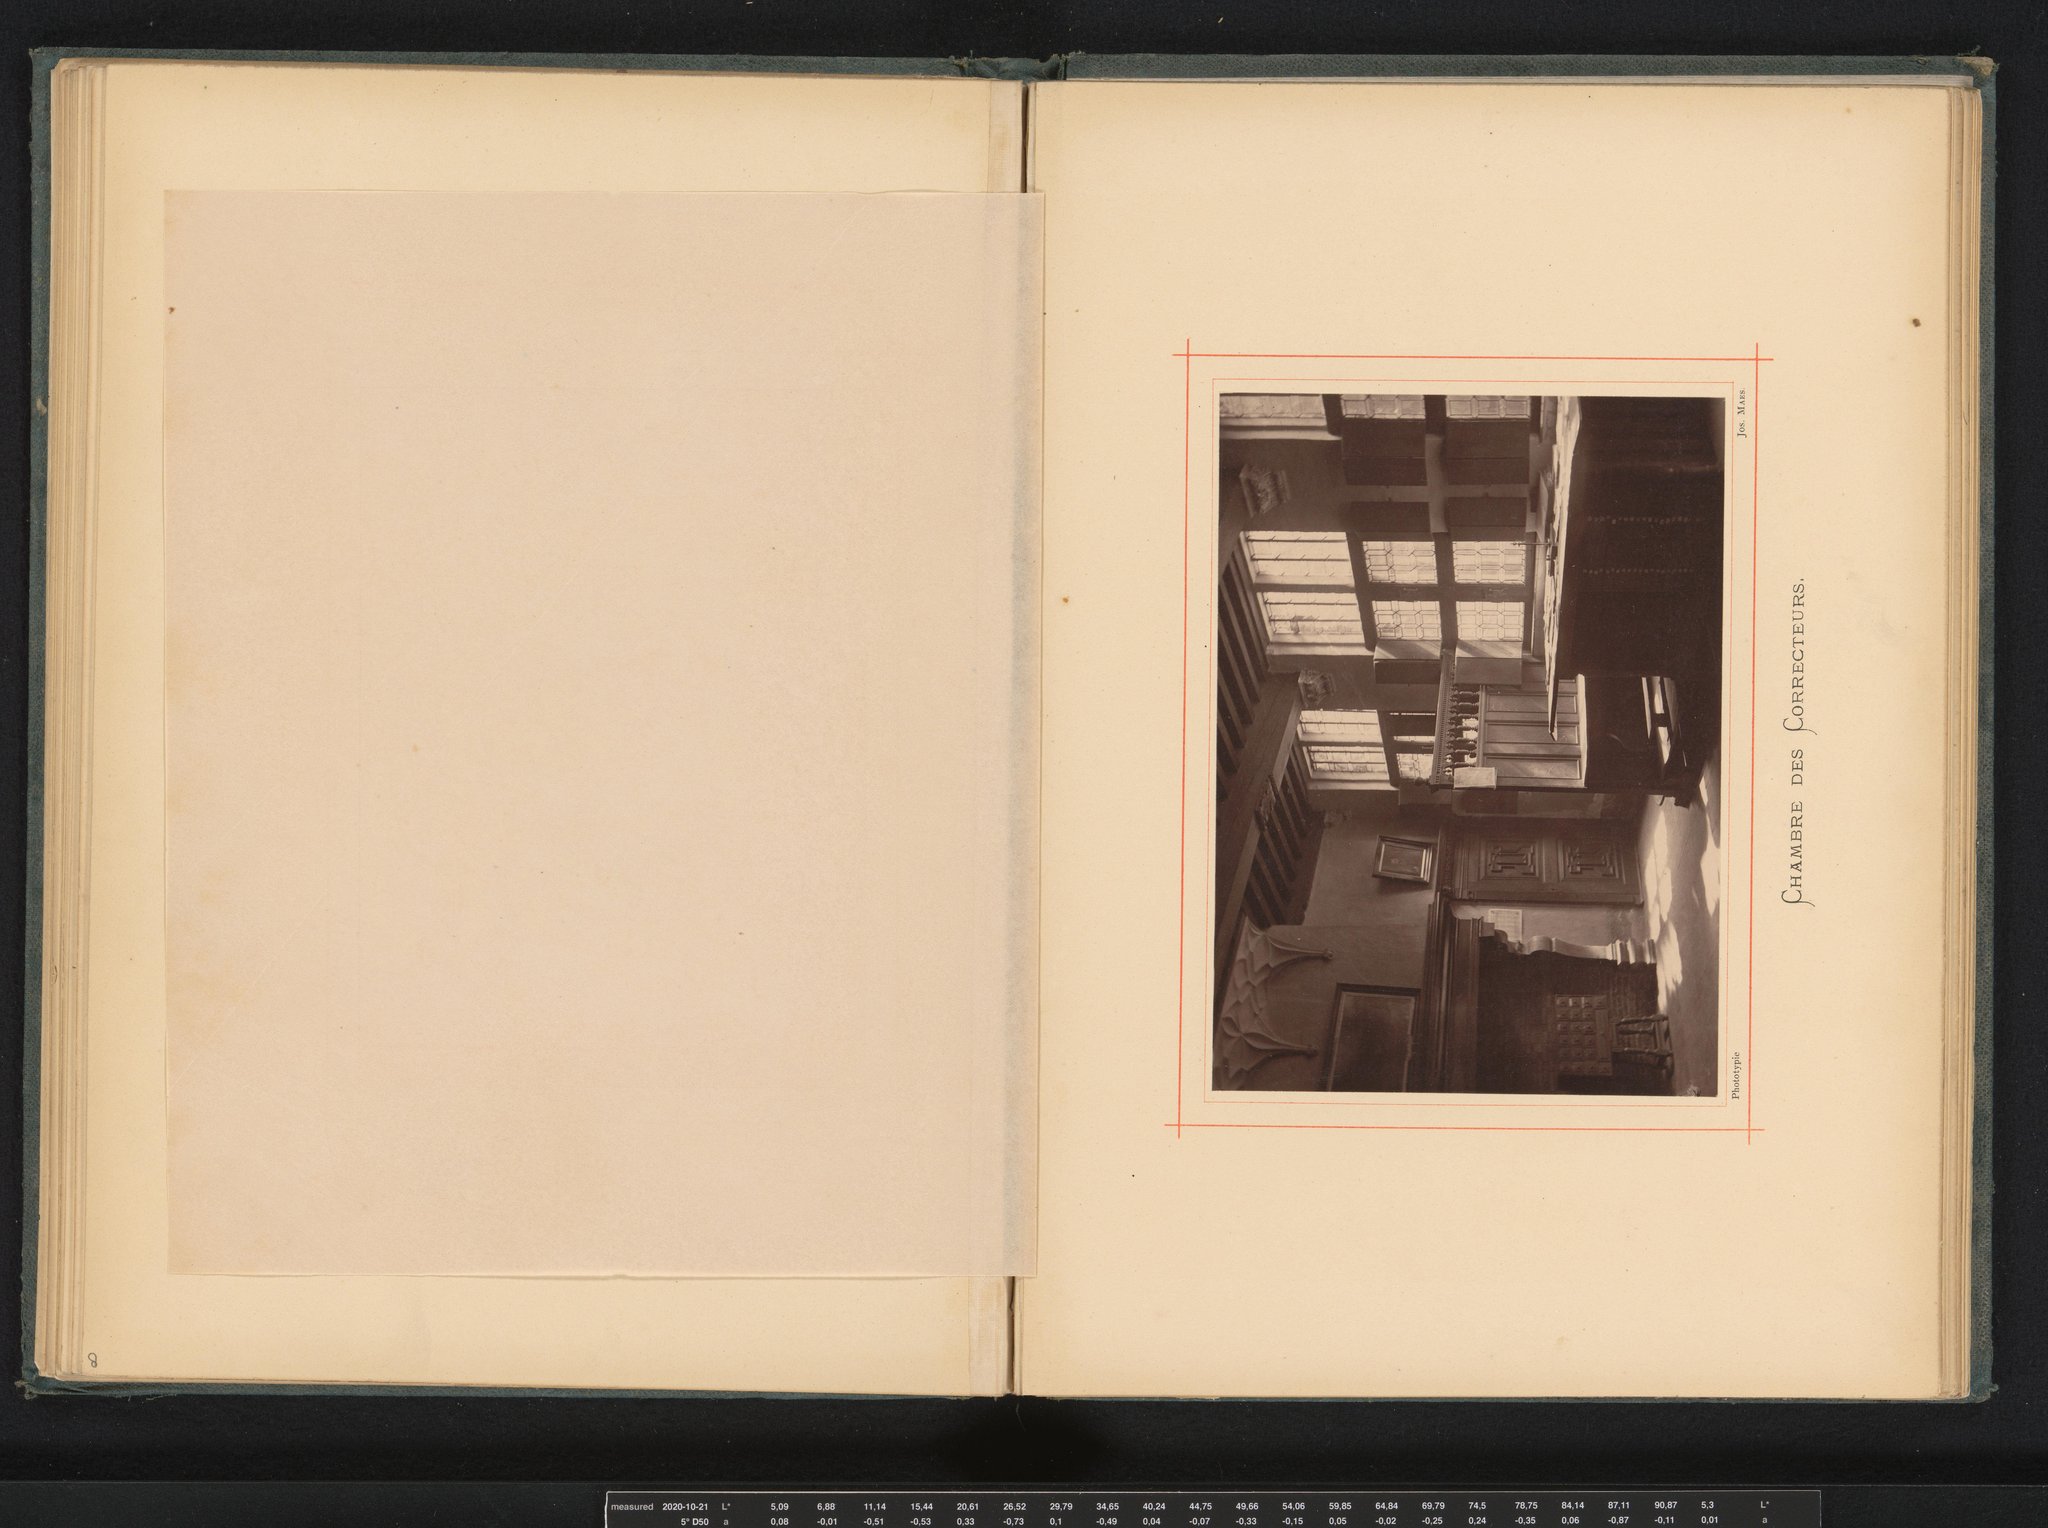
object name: page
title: Interieur van de correctors kamer het huis van Christoffel Plantijn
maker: joseph maes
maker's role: fotograaf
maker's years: 1838-1908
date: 1873-1878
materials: paper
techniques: woodburytype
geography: antwerp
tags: chest, bust